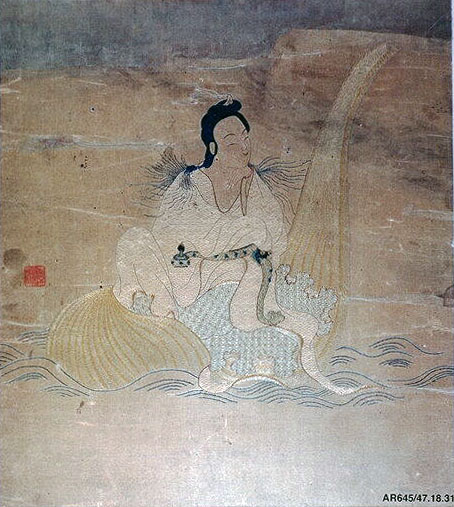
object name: album leaf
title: Bodhisattva Guanyin Riding a White Lotus Petal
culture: chinese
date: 1601-1800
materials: metal thread, silk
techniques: embroidery, weave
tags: buddhism,bodhisattvas